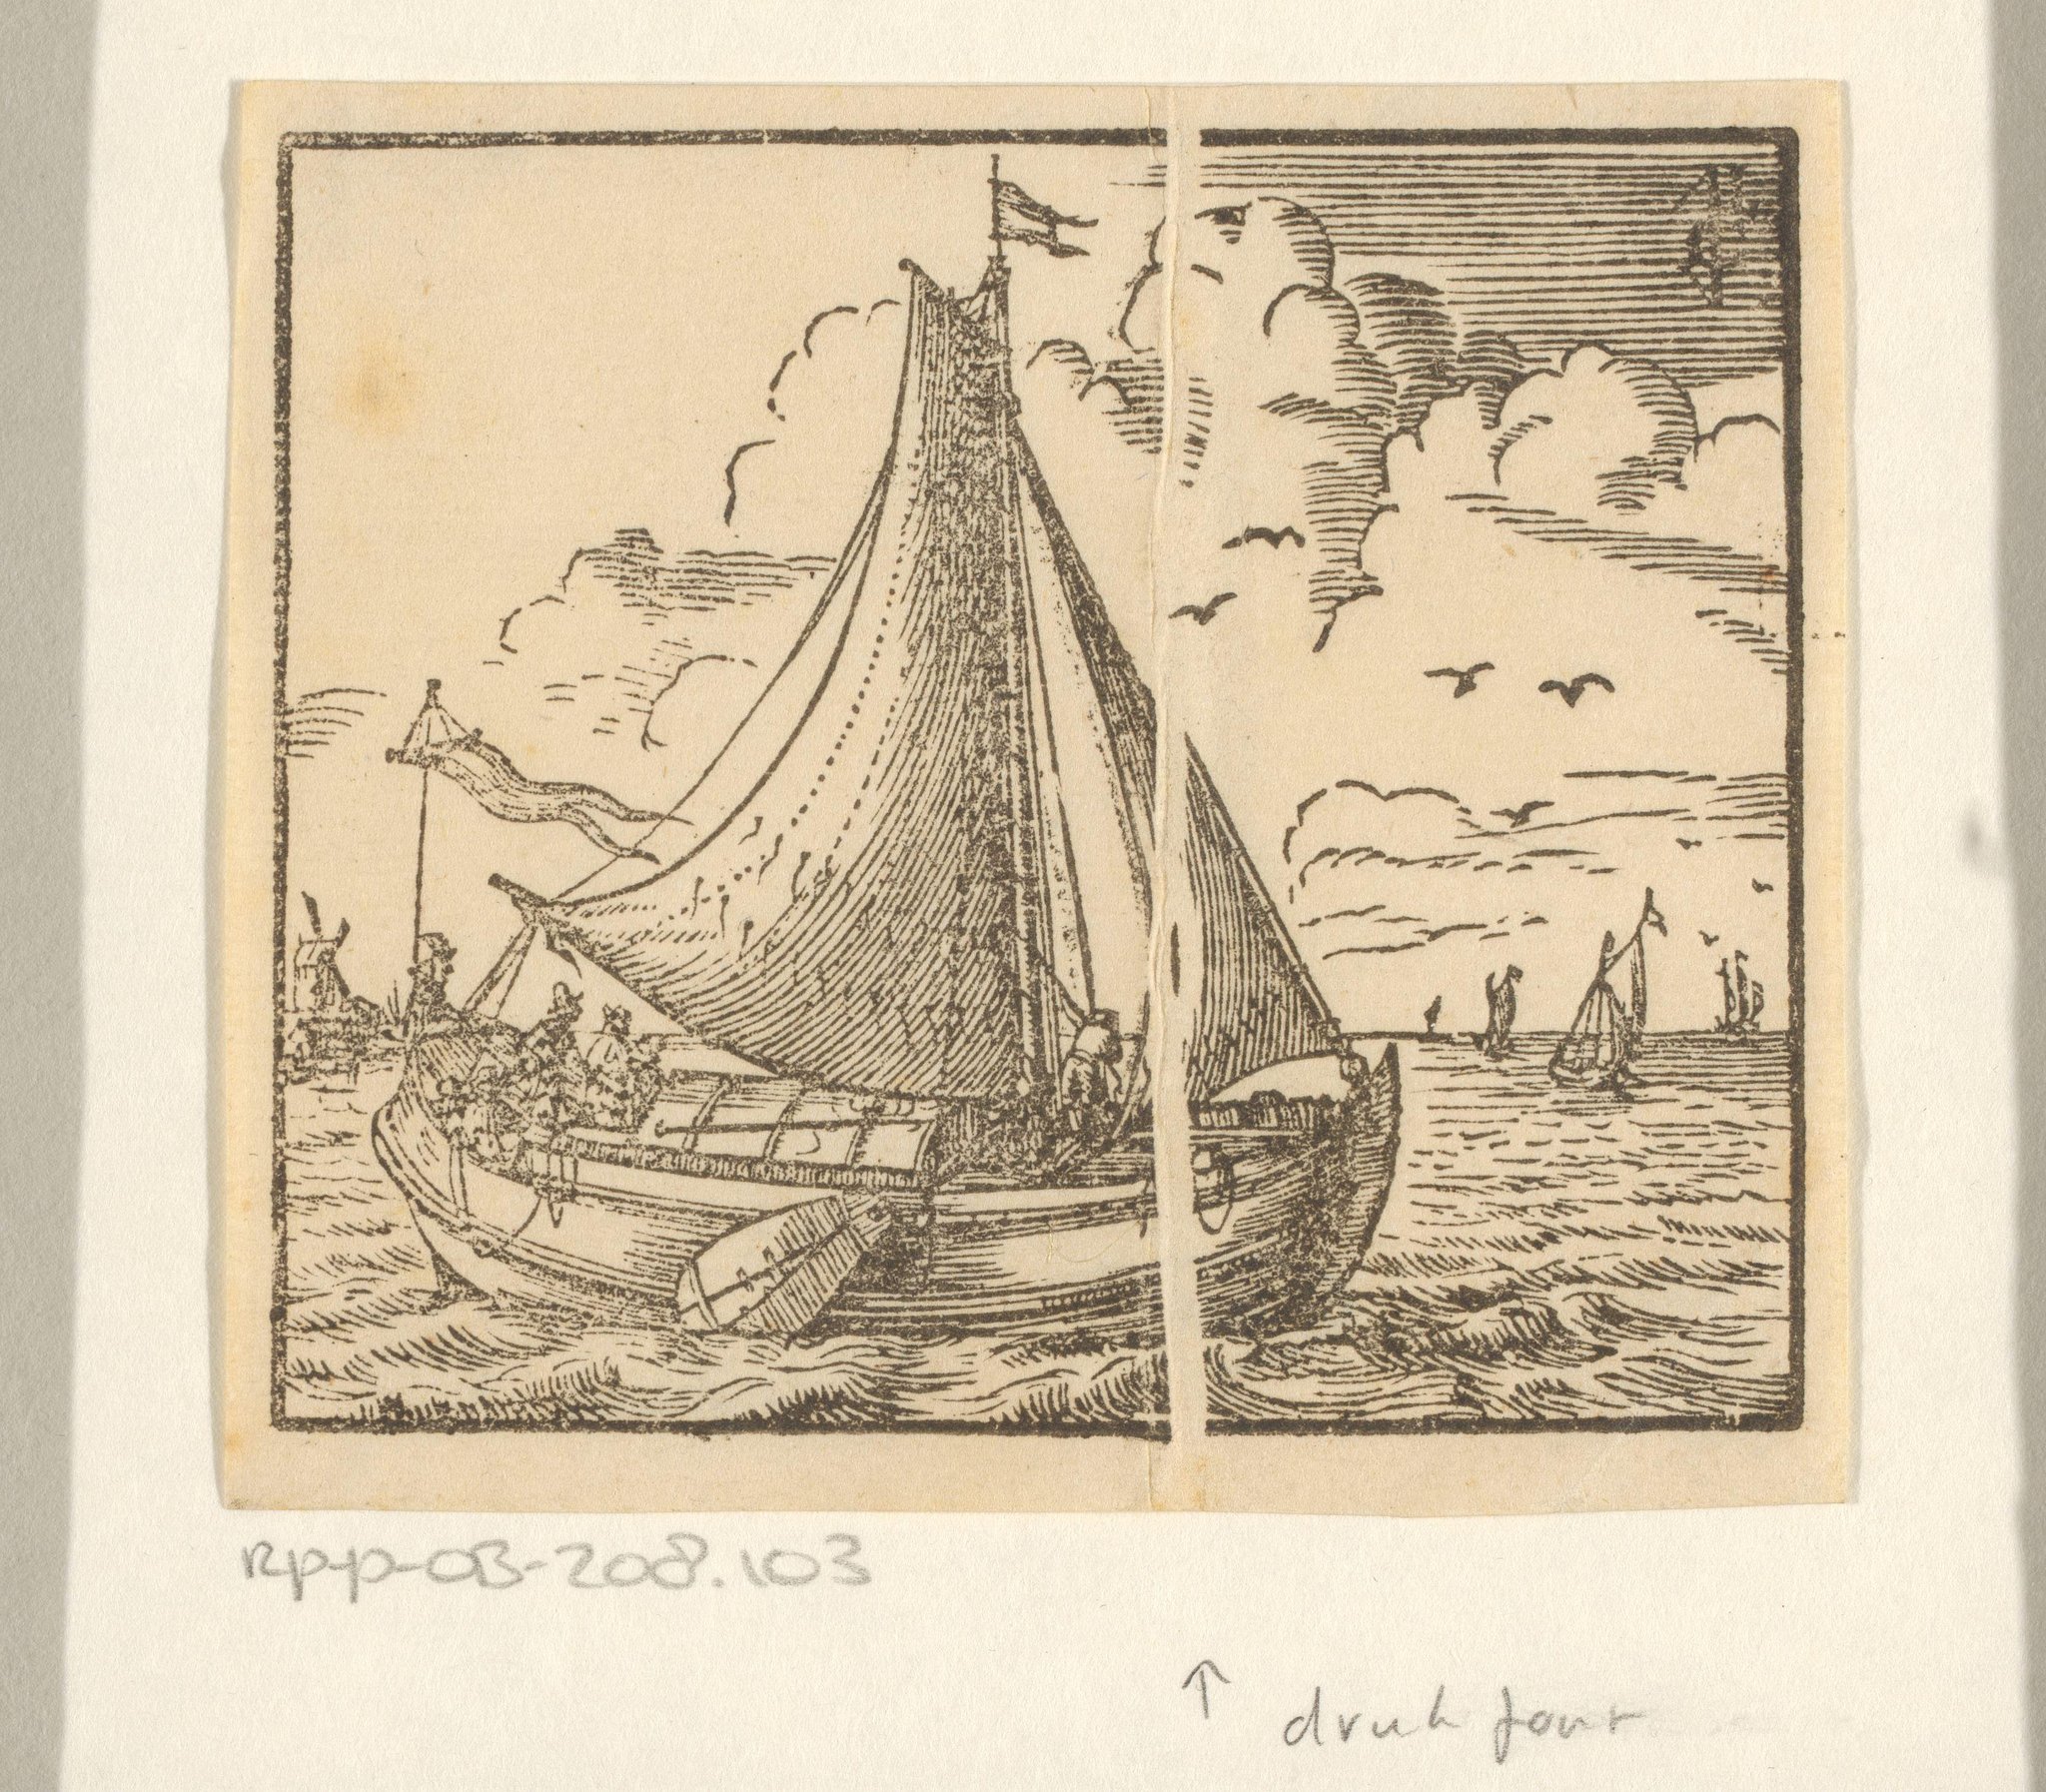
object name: print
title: Zeilschip nabij een kust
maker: isaac vincentsz. van der vinne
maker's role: draughtsman, print maker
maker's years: 1665-1740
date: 1681-1740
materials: paper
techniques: woodcut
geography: netherlands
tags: ships (in general), sea and coastal fishery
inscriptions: collector's mark: Lugt 698, collector's mark: Lugt 2228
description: Rechtsboven het monogram van de uitgever Abraham Casteleyn.